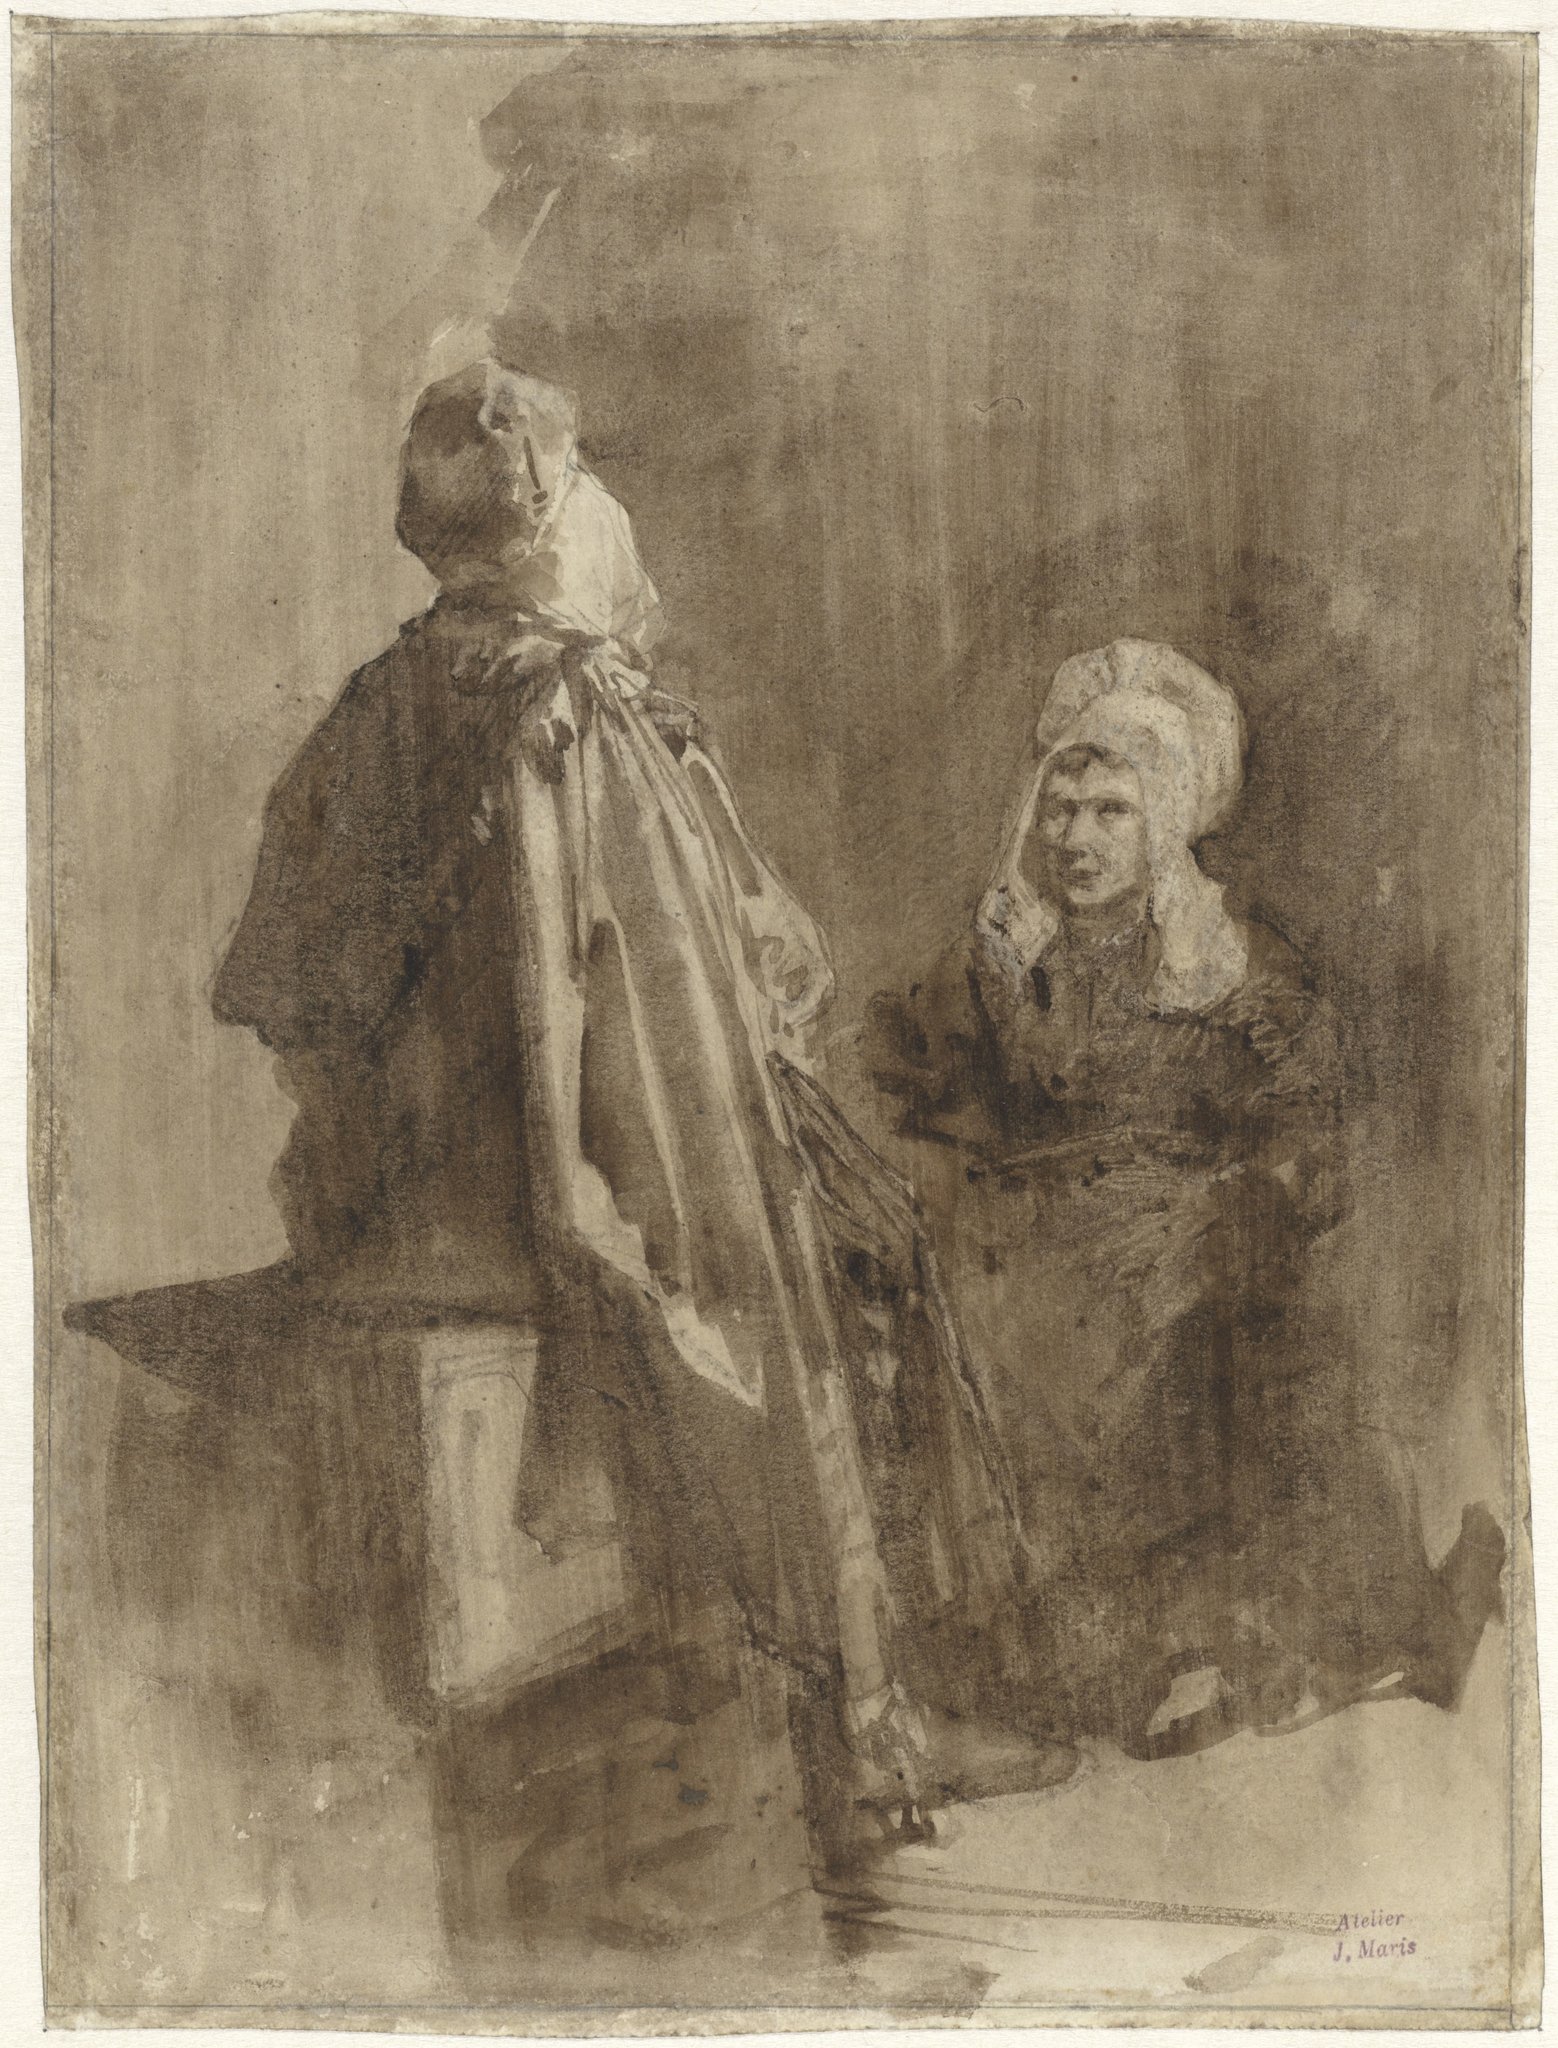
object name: drawing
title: Twee vissersvrouwen in gesprek over een onderdeur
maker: jacob maris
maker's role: draughtsman, painter, print maker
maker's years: 1837-1899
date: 1847-1899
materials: paper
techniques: brush